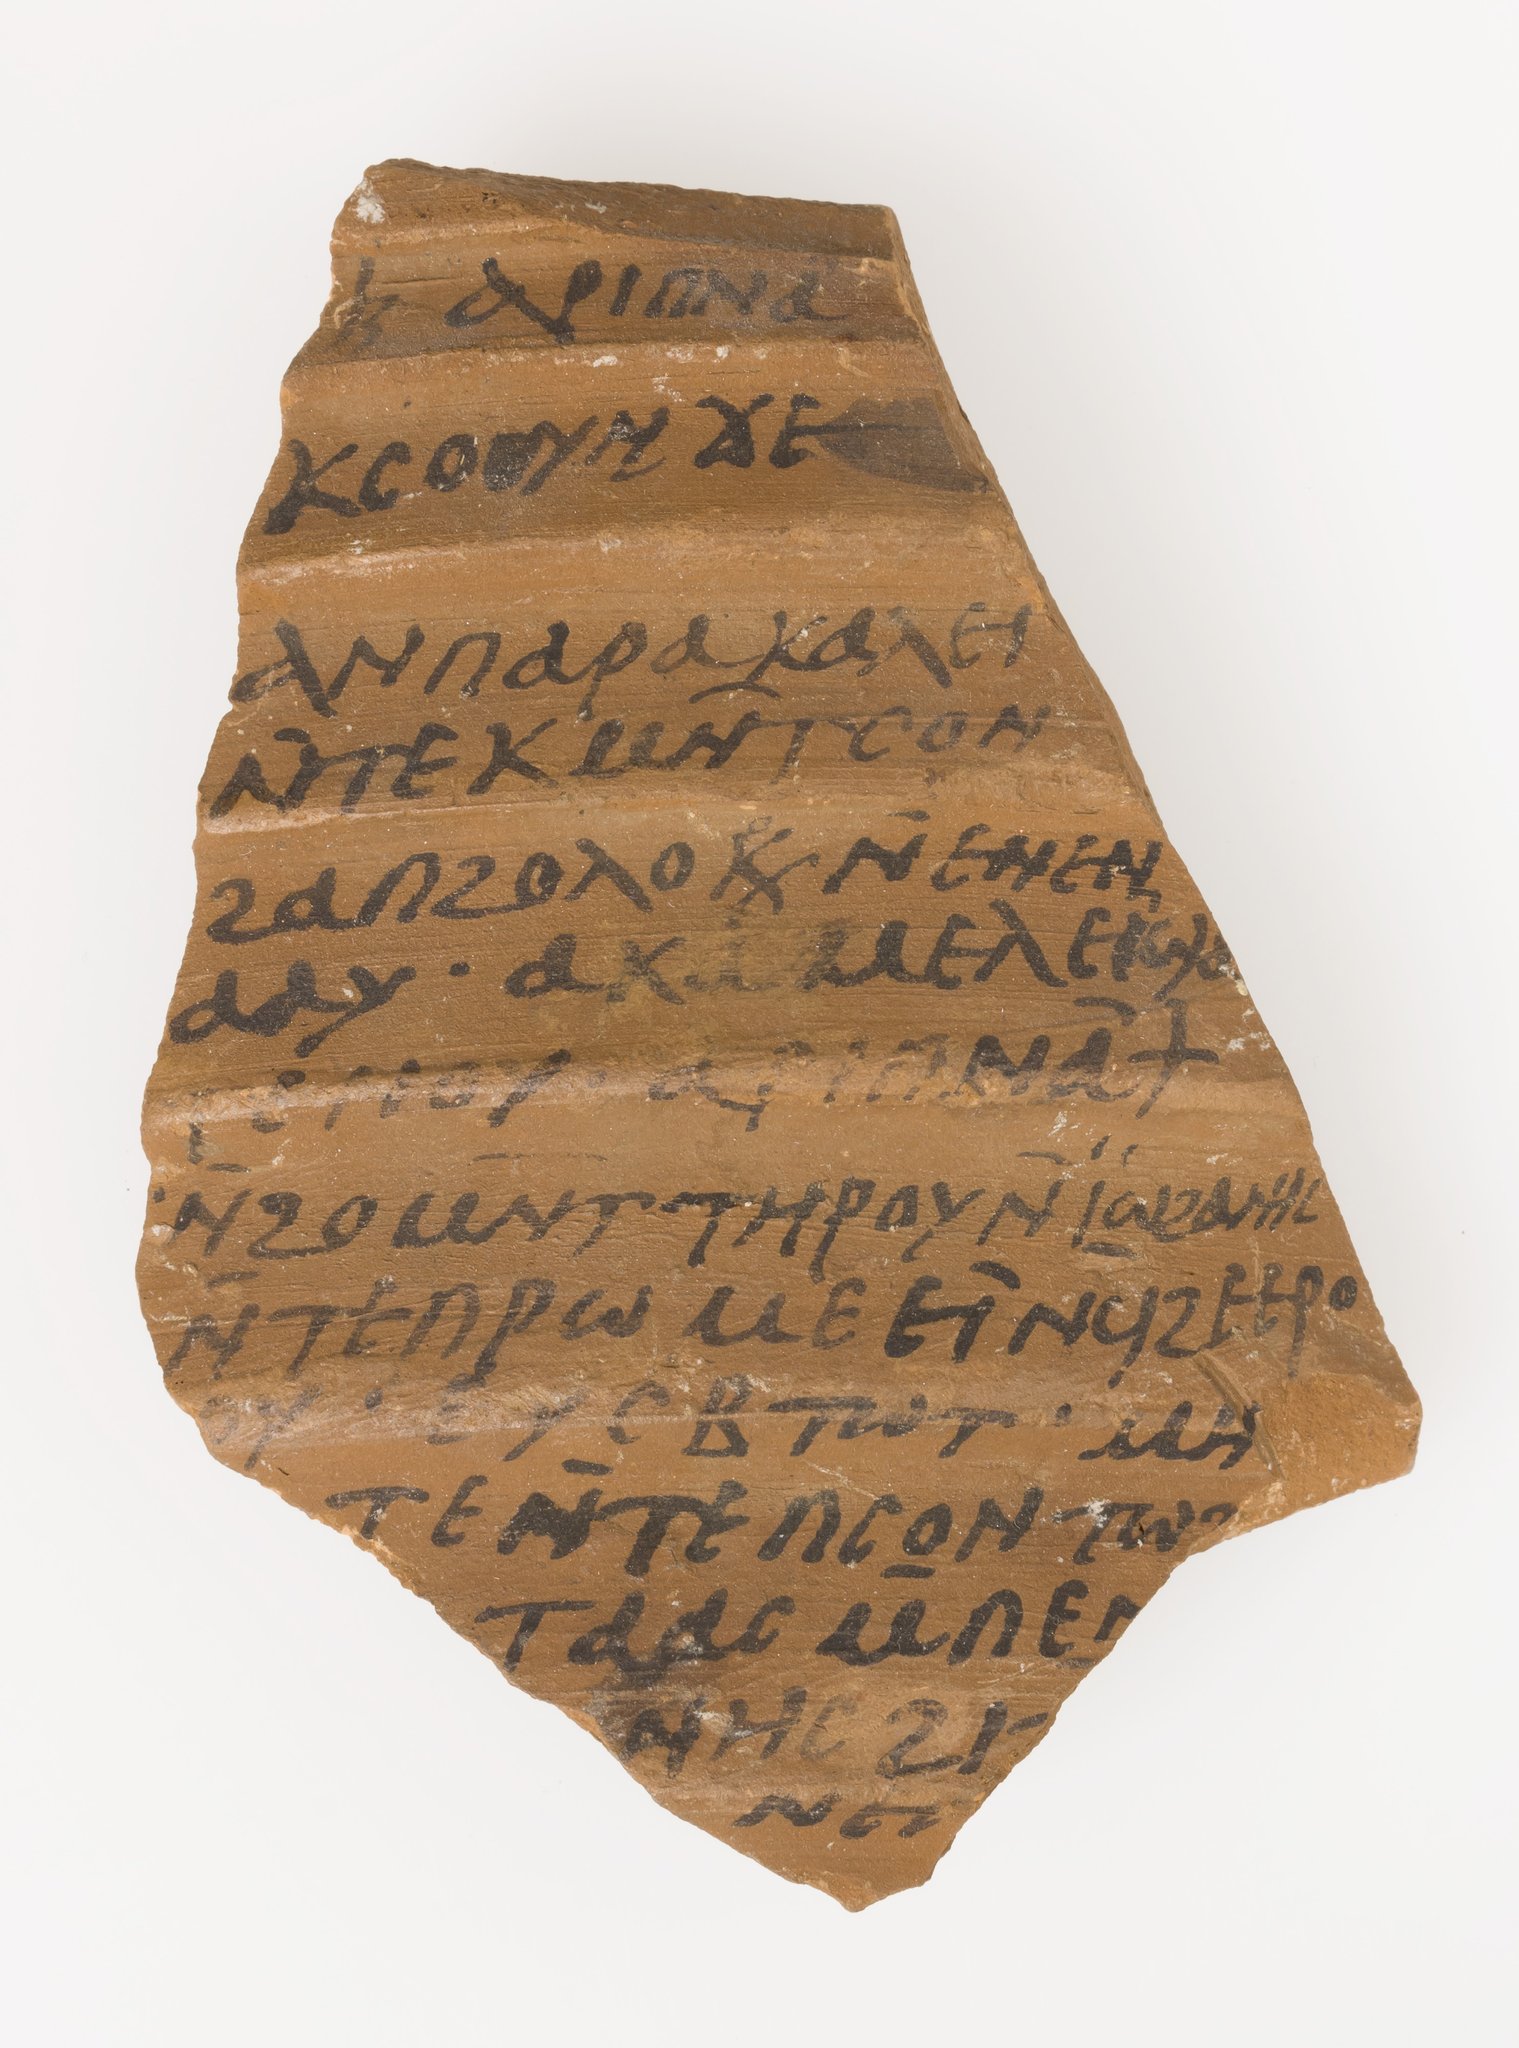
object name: ostrakon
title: Ostrakon from the Brethren (?) to John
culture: coptic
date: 580-640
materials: ink, pottery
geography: egypt